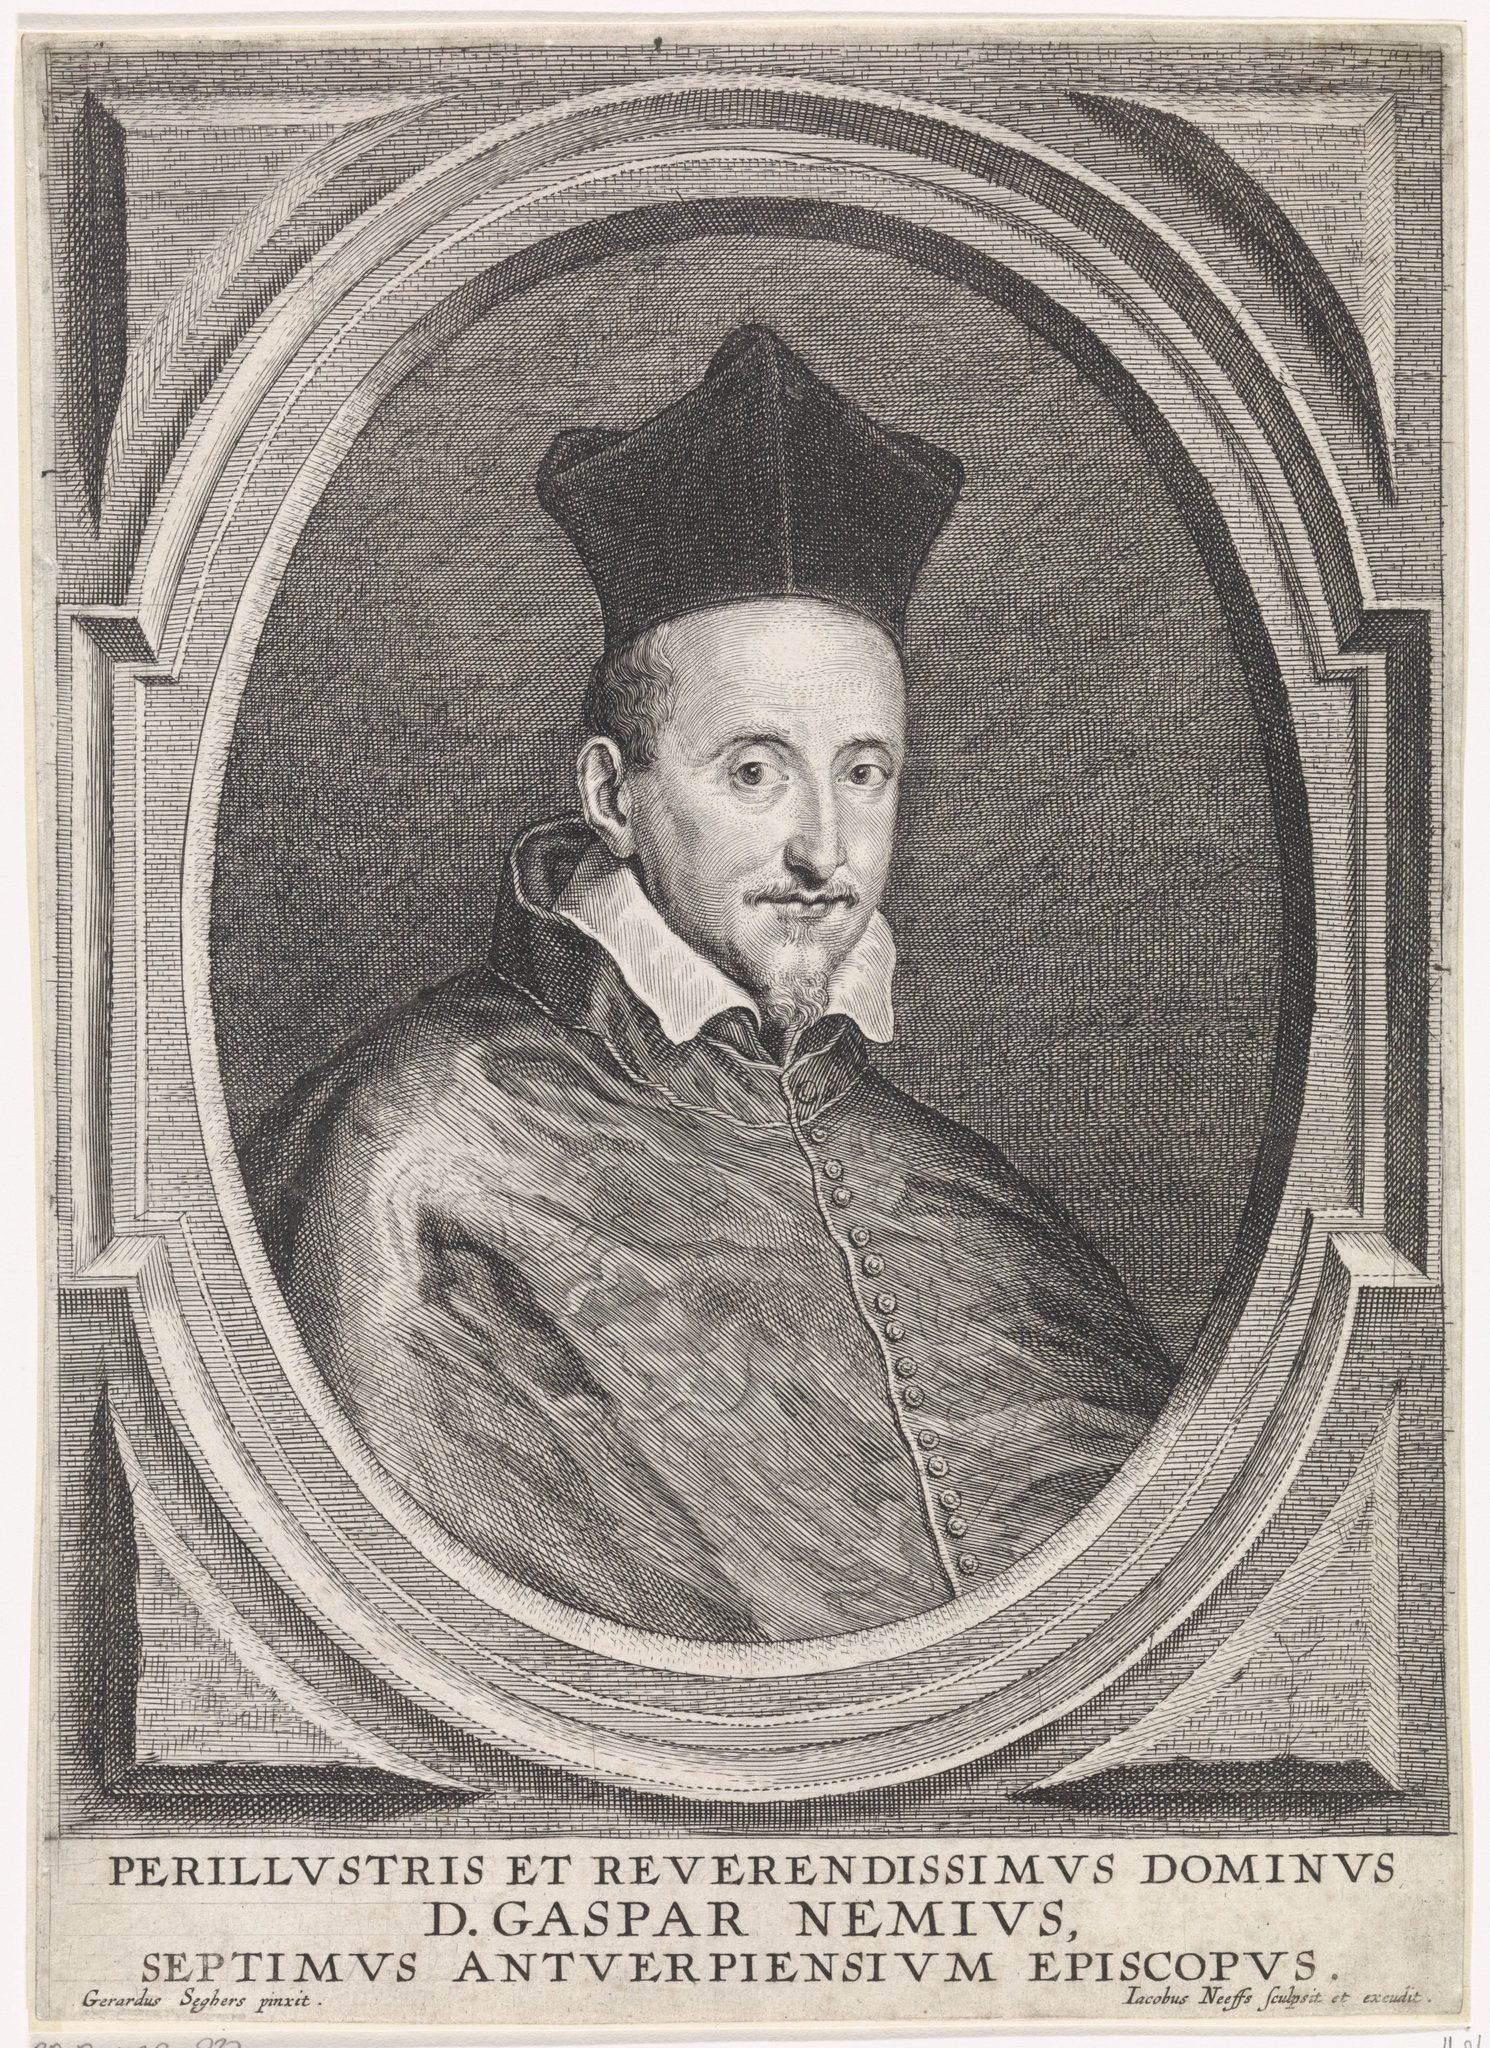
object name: print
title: Portret van bisschop Gaspar Nemius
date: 1620-1680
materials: paper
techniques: engraving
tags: gaspar nemius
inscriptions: inscription: ‘F.’, collector's mark: Lugt 2228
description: Gaspar Nemius, bisschop van Antwerpen, draagt een biretta op het hoofd en is gekleed in een mozetta. Buste naar rechts in een ovaal. Onderaan in de marge een drieregelige tekst in het Latijn.